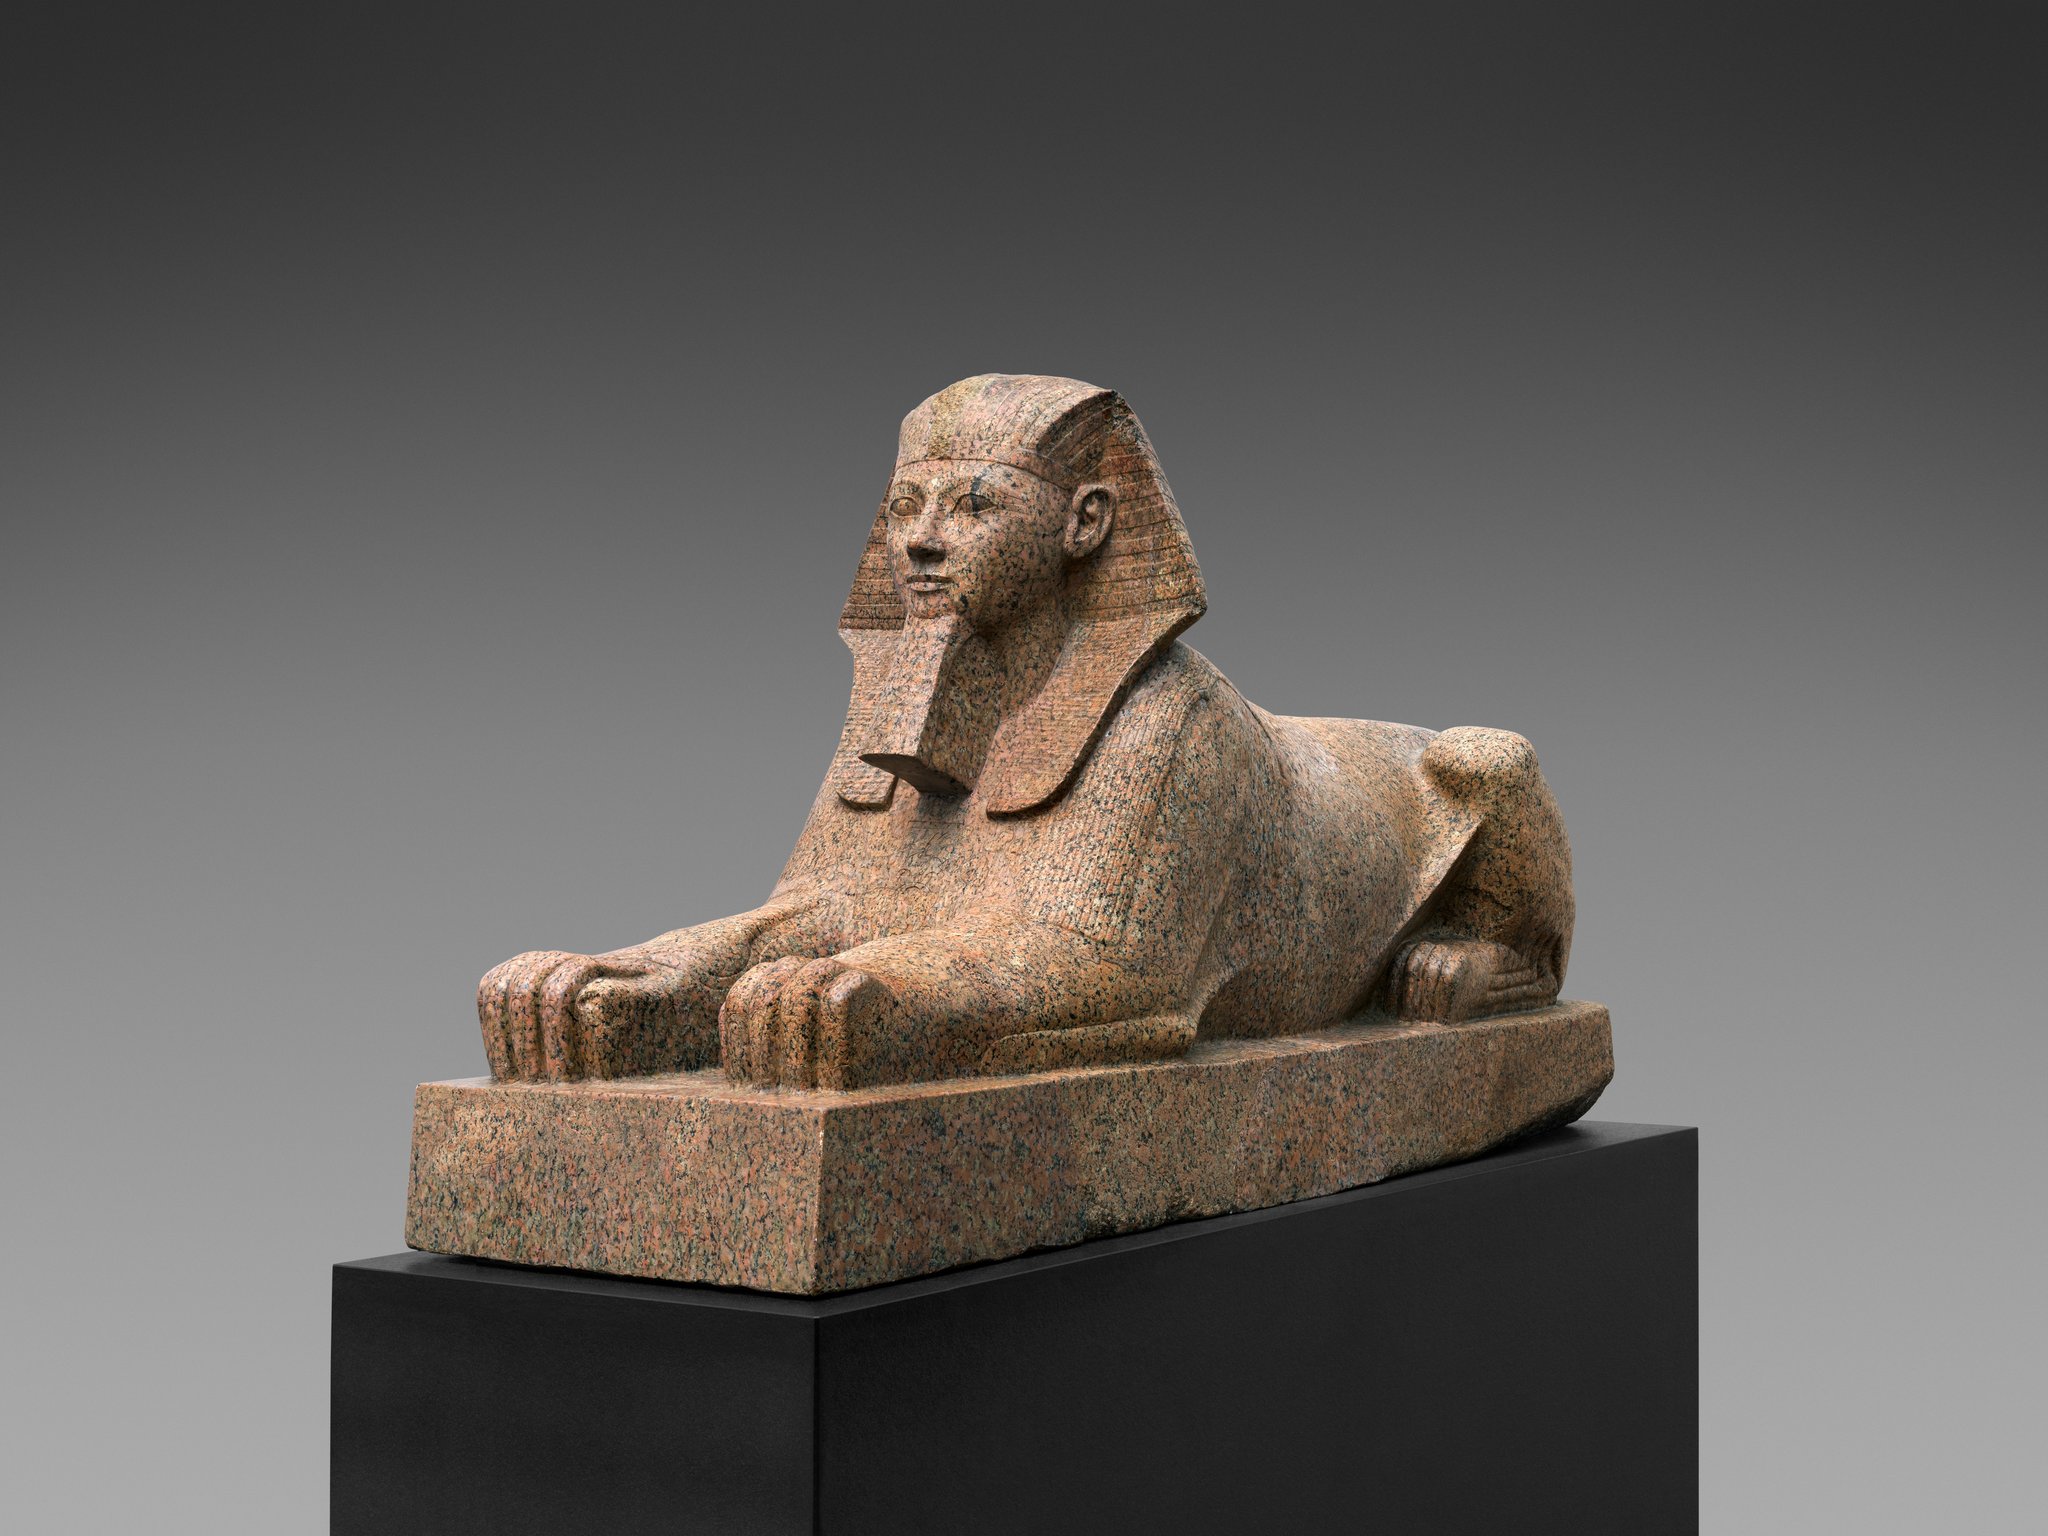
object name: sphinx, hatshepsut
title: Sphinx of Hatshepsut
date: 1479-1458 BCE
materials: granite, paint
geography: egypt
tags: sphinx